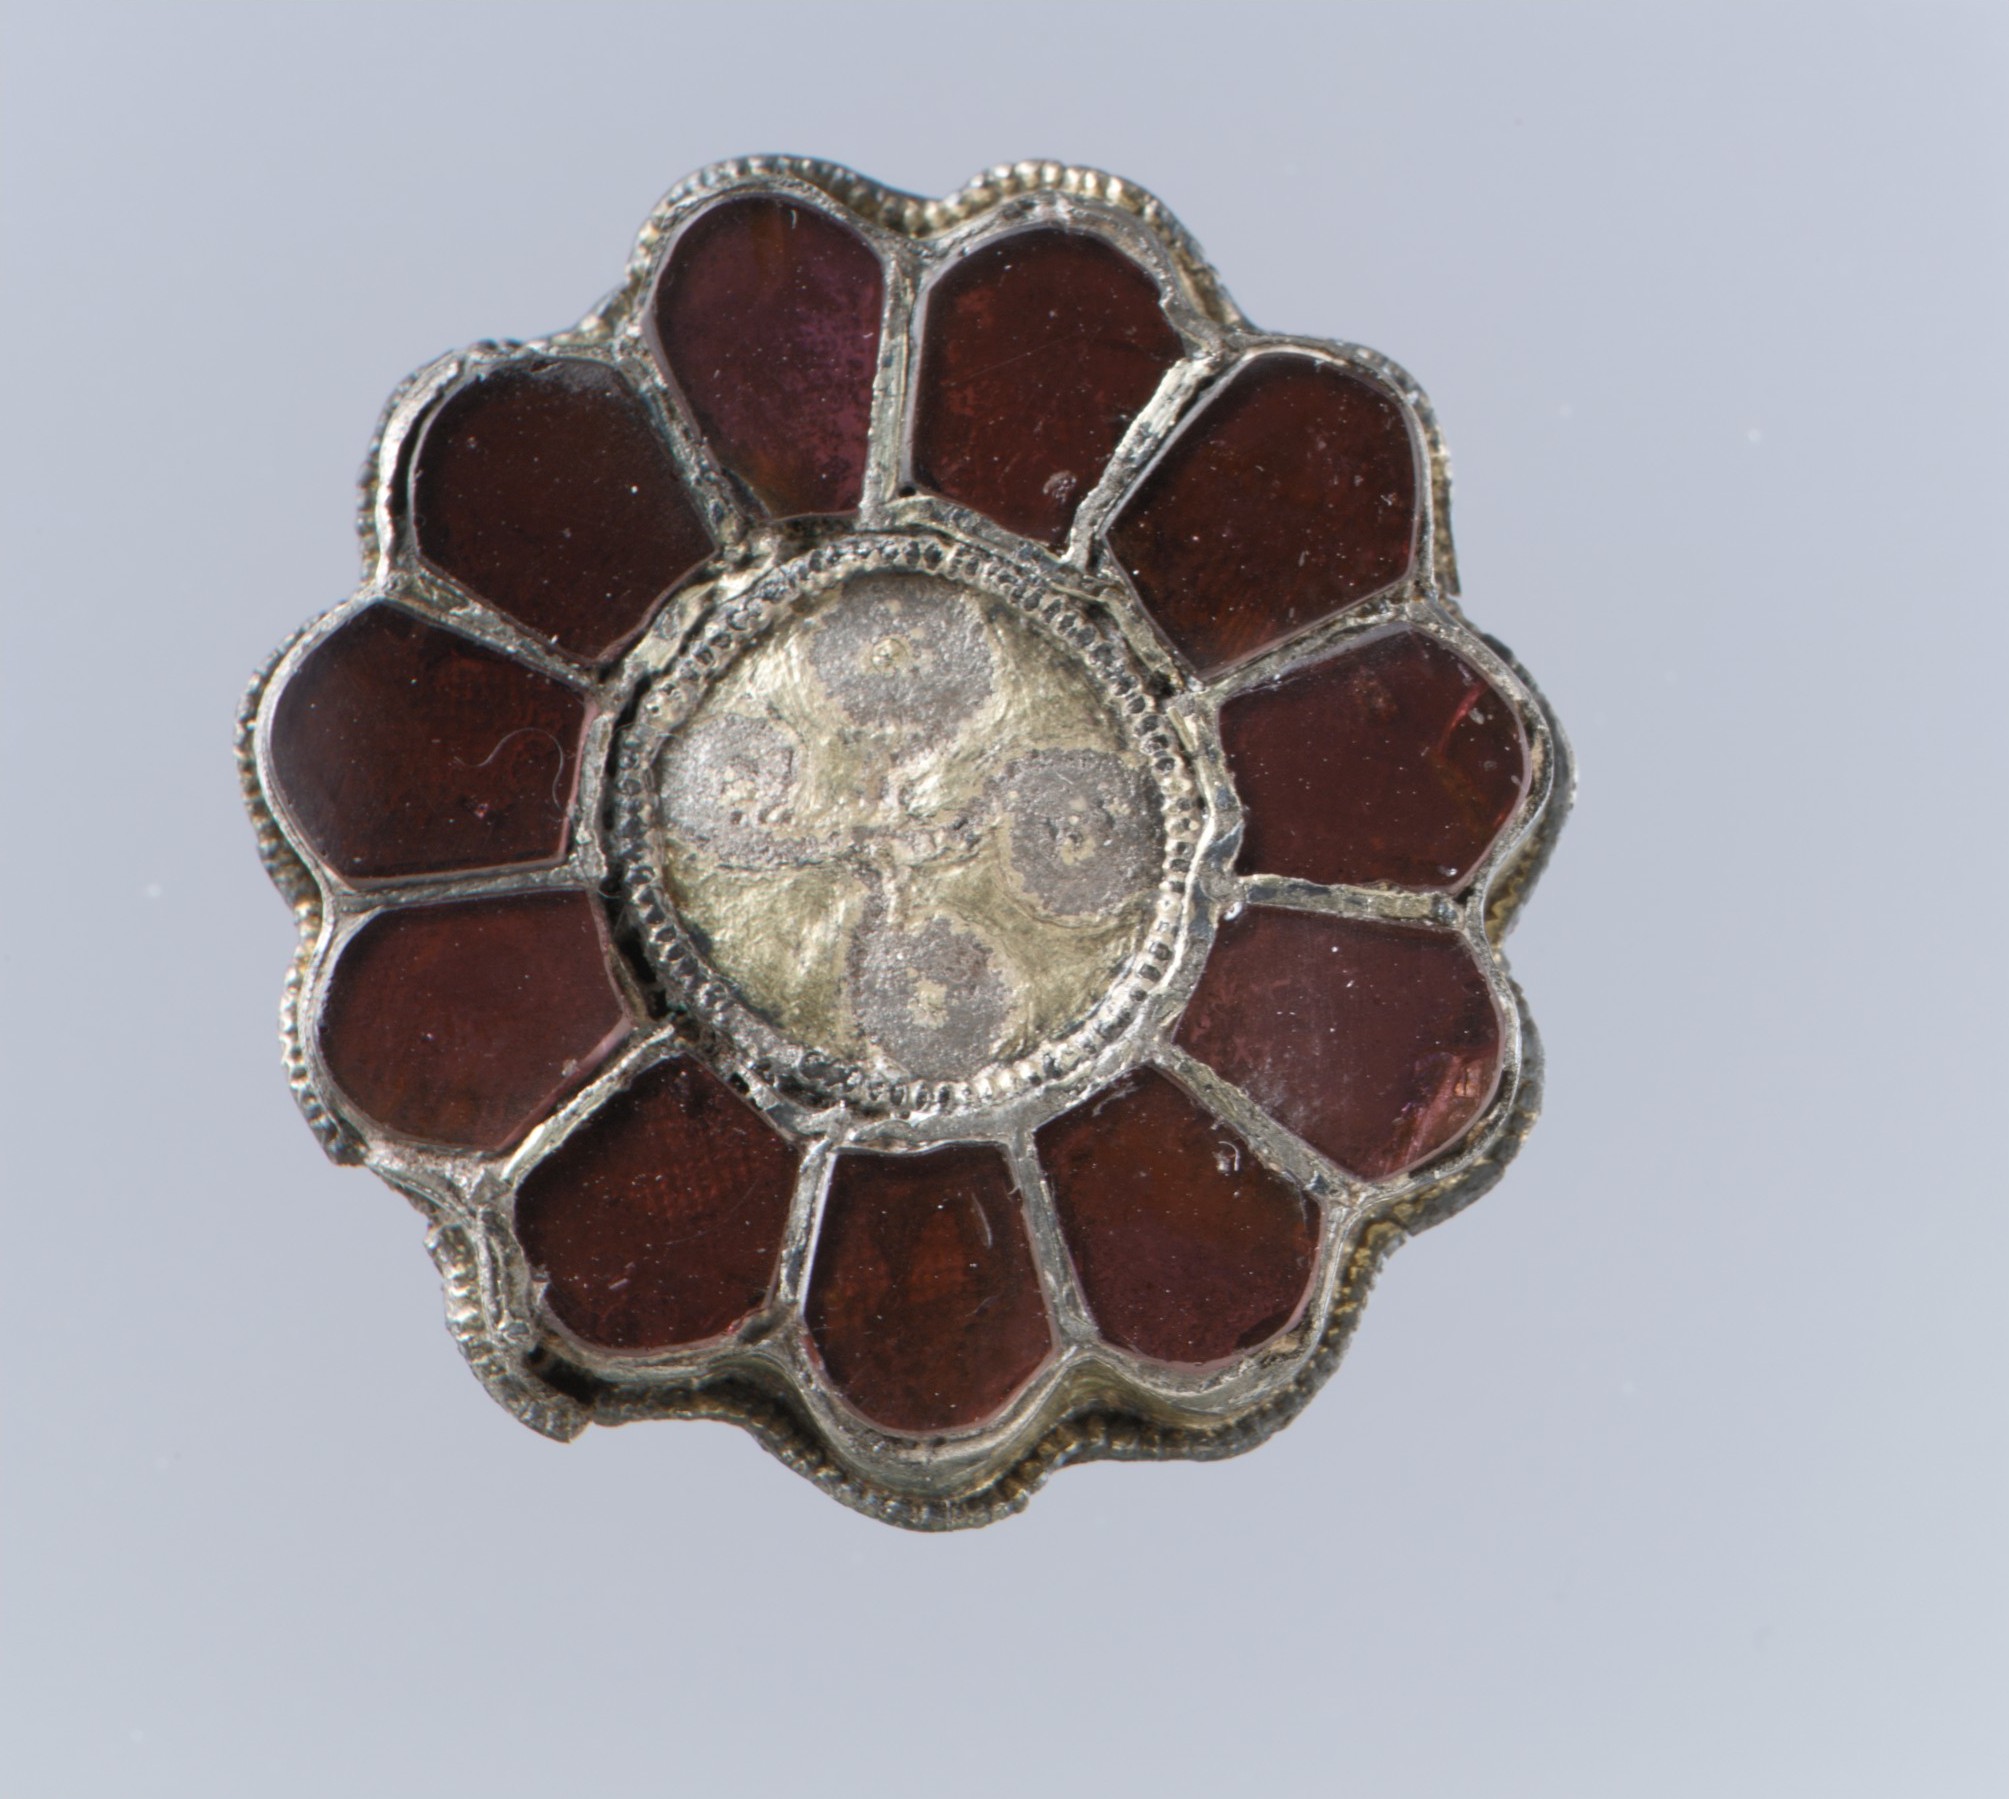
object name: brooch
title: Rosette Brooch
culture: frankish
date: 550-650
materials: foil, garnet, gilt silver, glass, pearl, silver gilt